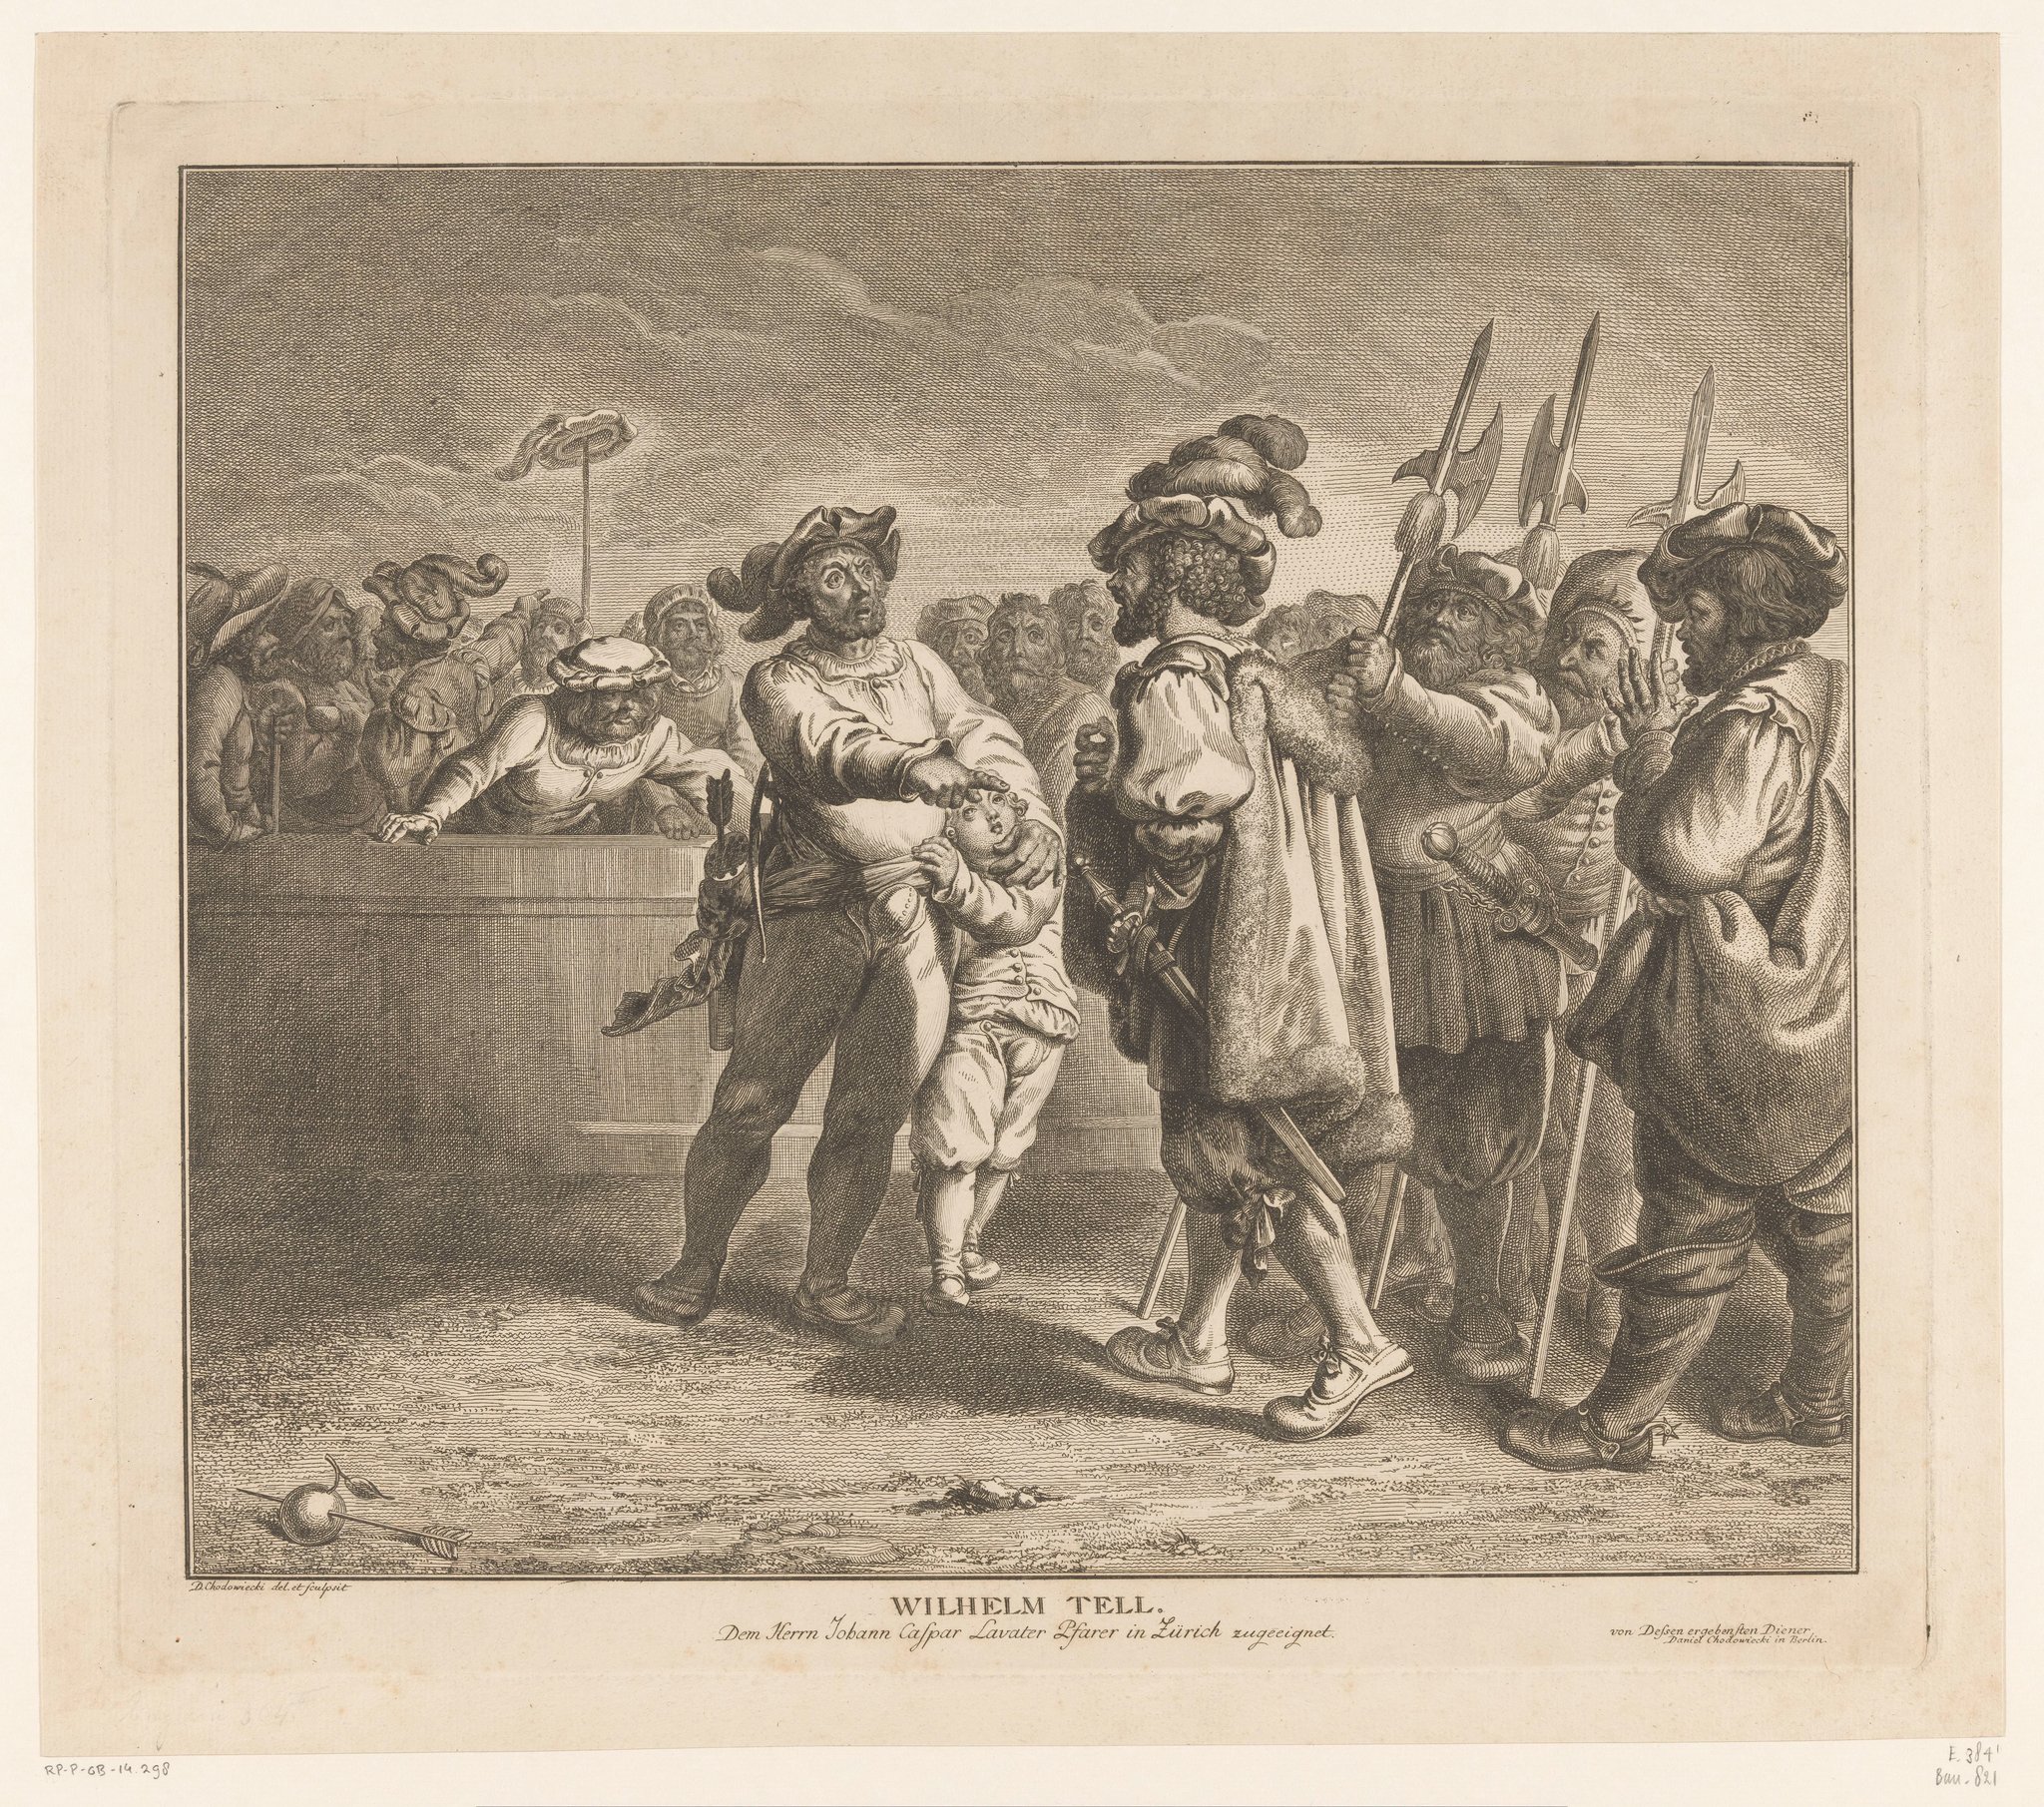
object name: print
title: Wilhelm Tell in conflict met Gessler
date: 1781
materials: paper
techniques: etching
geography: berlin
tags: william tell, fruits: apple, archer's weapons: arrow, head-gear: hat, imprisonment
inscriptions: collector's mark: Lugt 2228